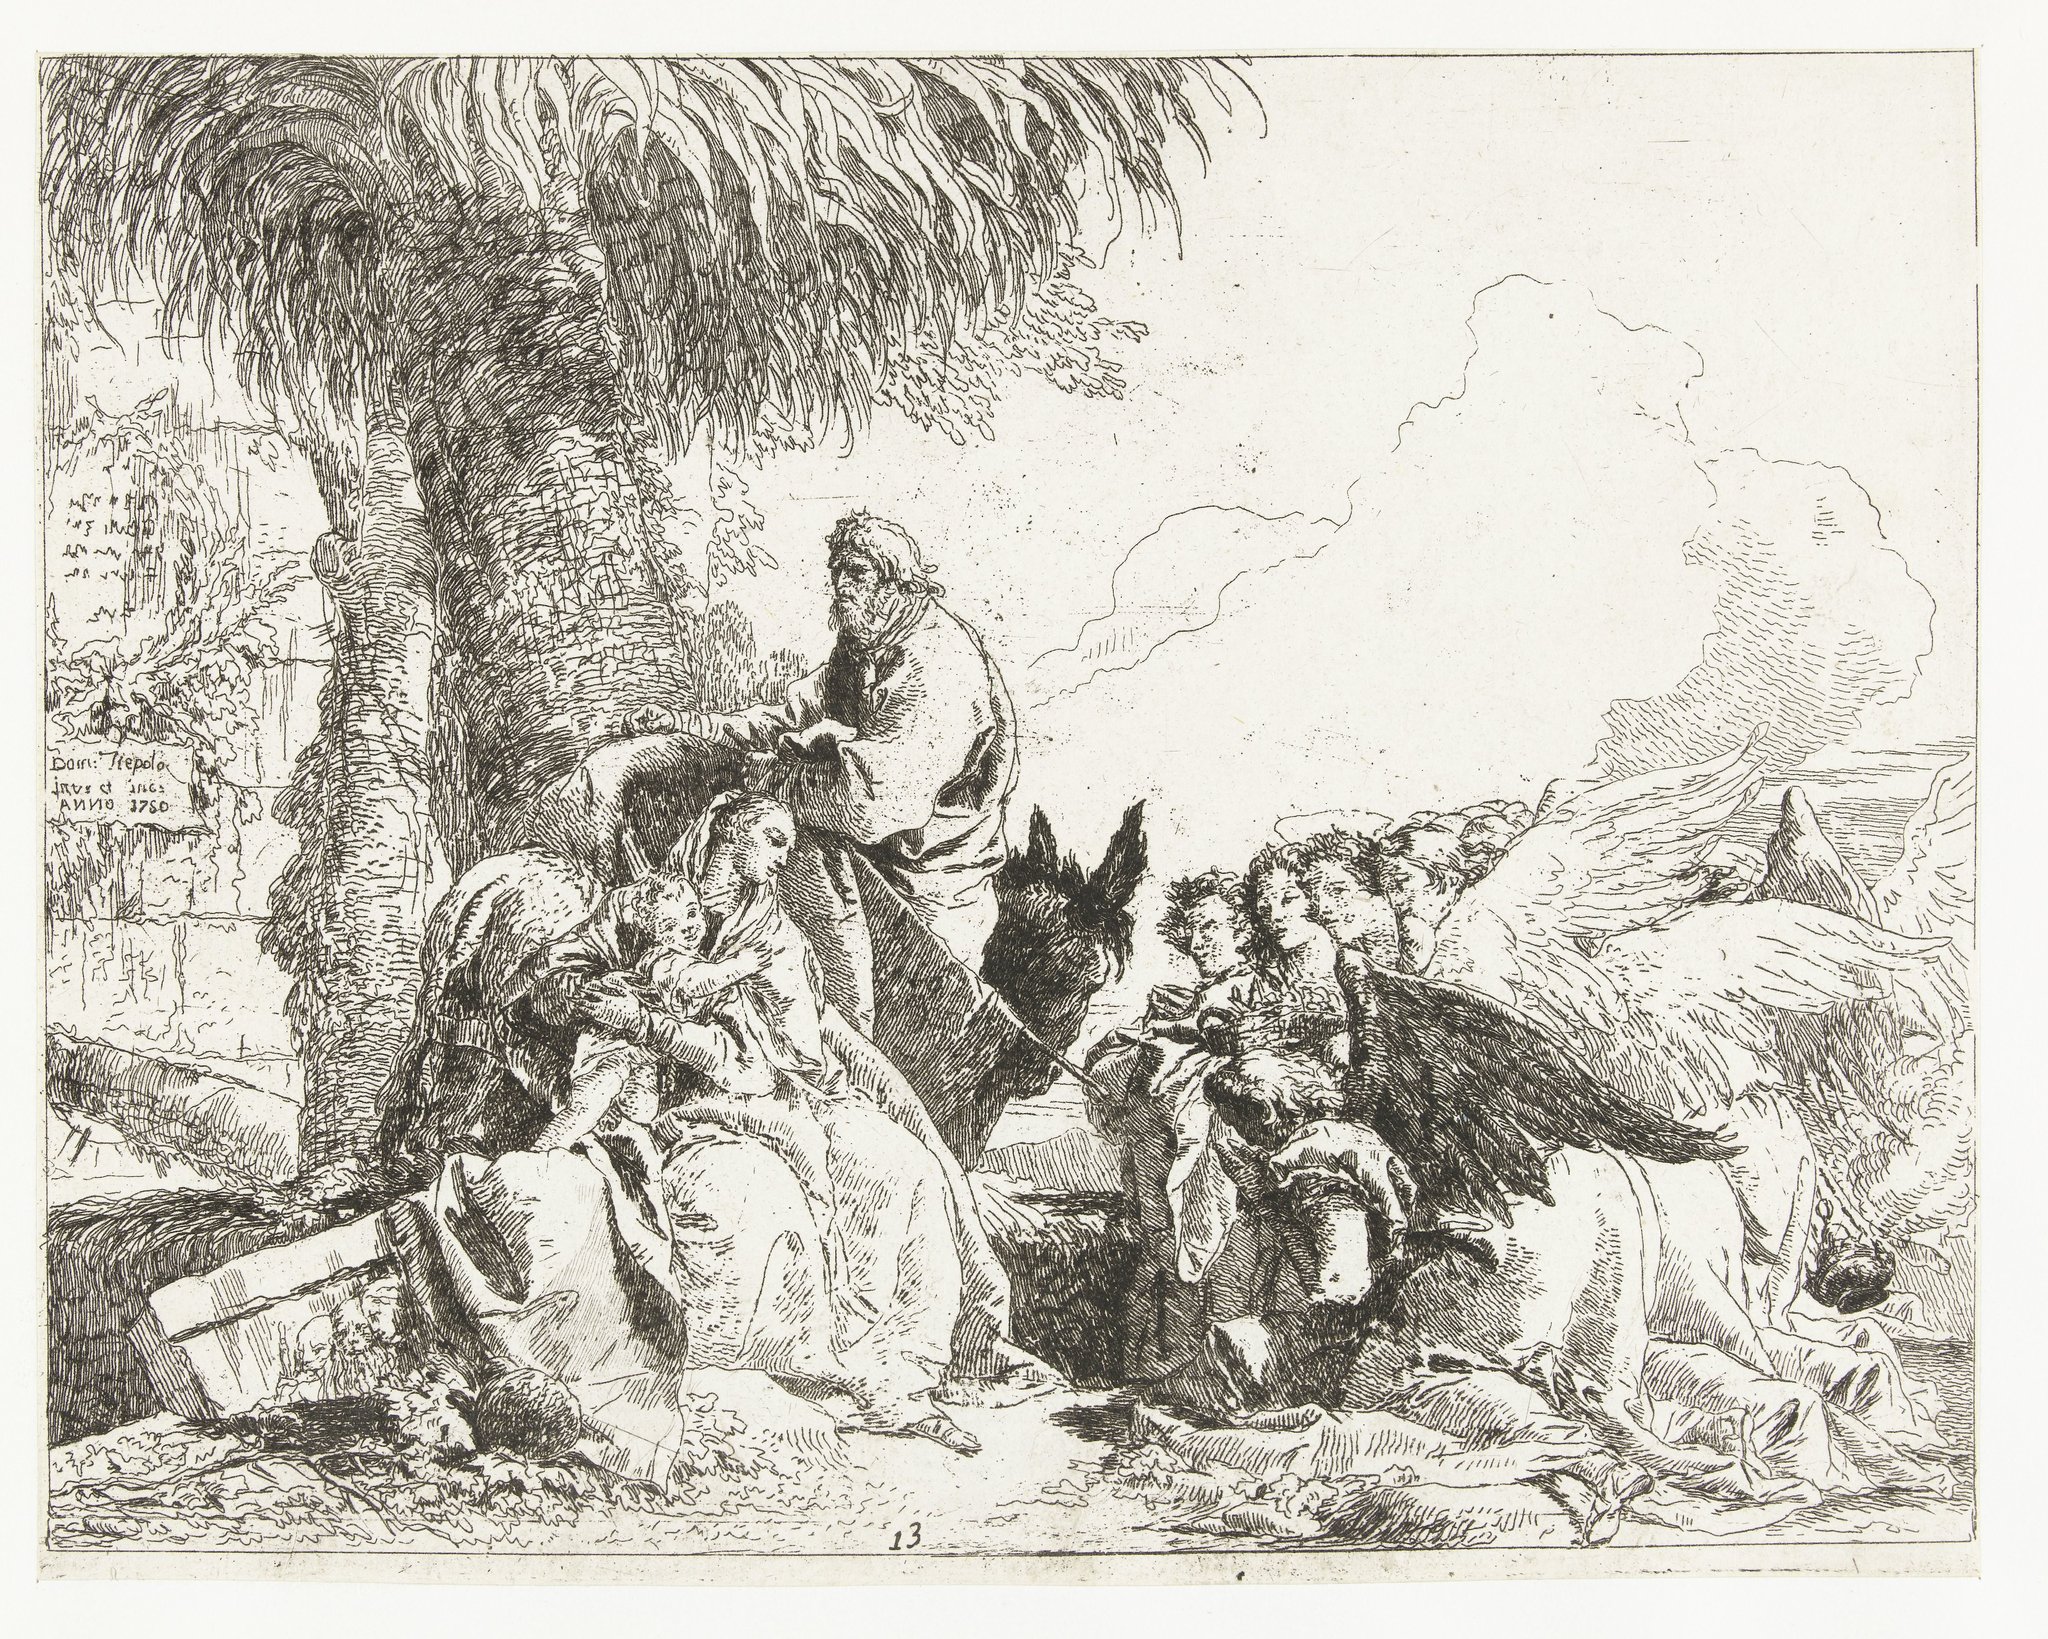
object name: print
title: Rust op vlucht naar Egypte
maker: giovanni domenico tiepolo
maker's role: draughtsman, print maker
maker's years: 1727-1804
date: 1750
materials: paper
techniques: etching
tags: rest on the flight into egypt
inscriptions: collector's mark: Lugt 2760, collector's mark: Lugt 2228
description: Prent uit serie van zevenentwintig prenten met de Vlucht naar Egypte.